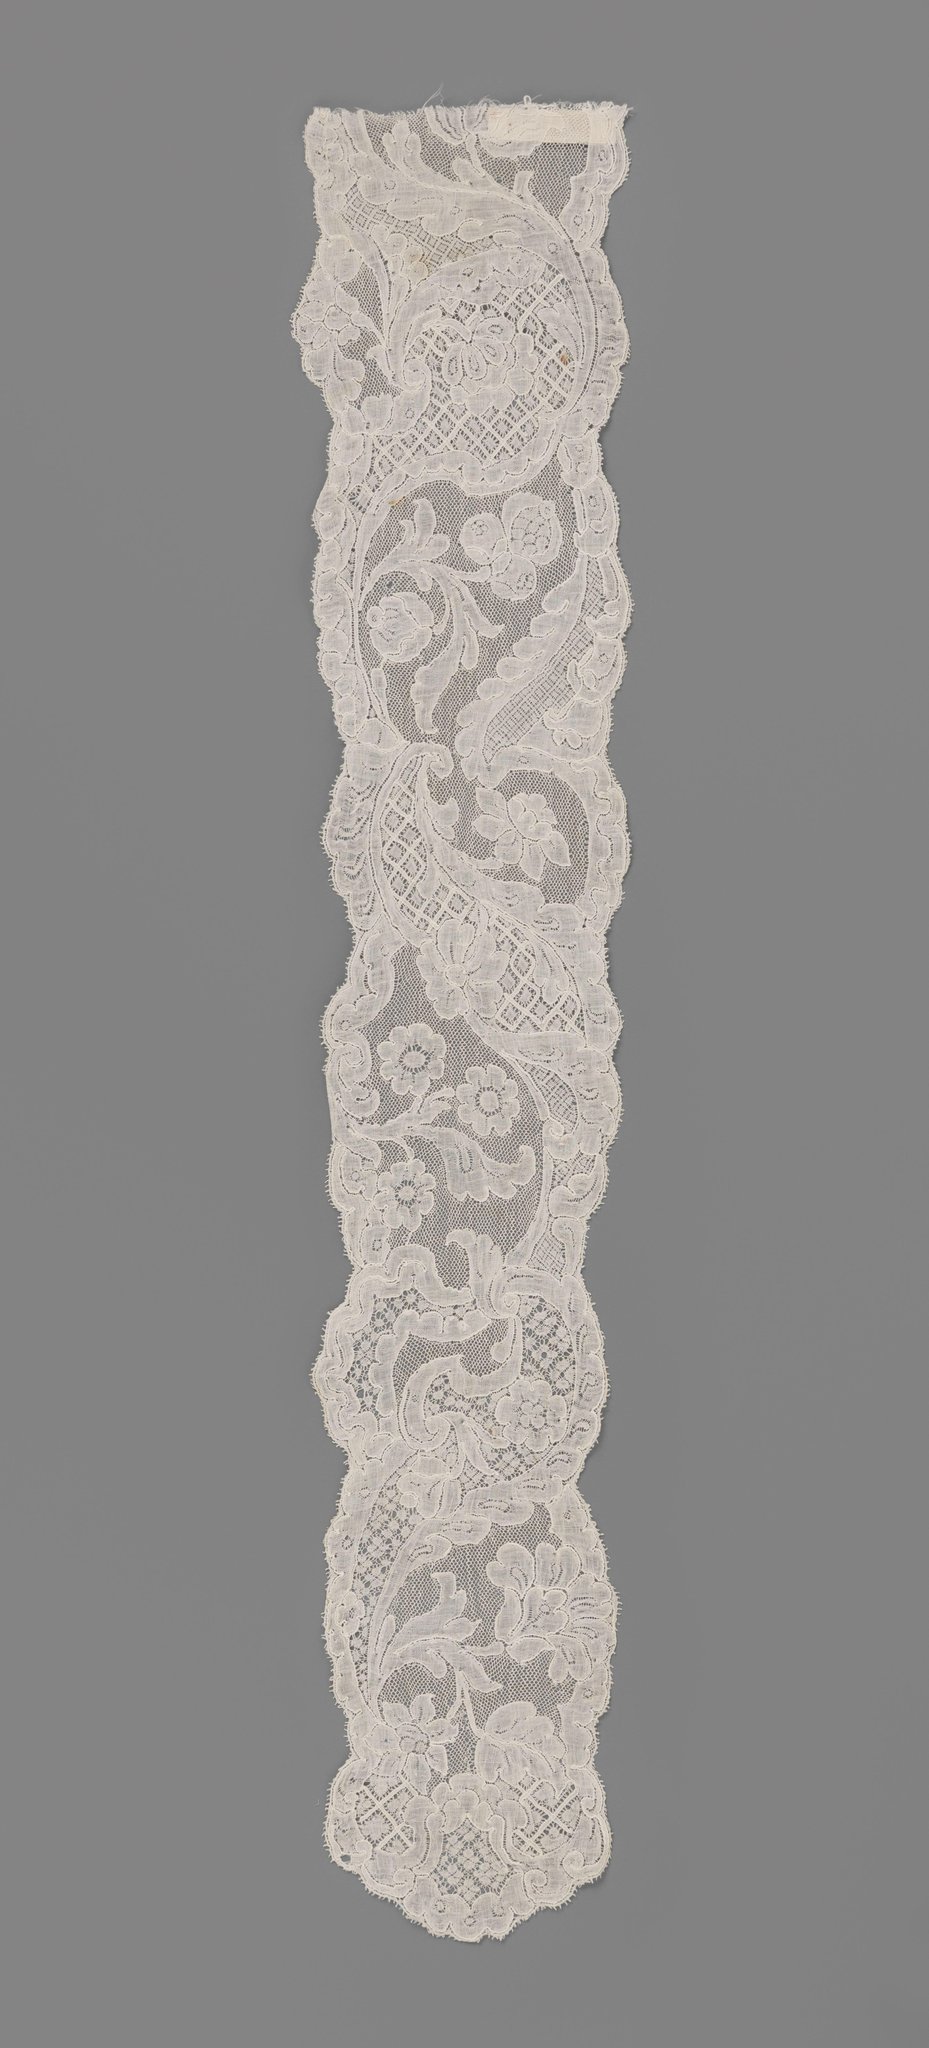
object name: womenswear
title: Mutsenslip (fragment) van Mechelse kant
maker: Anonymous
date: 1750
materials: linen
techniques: lace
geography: western europe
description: Barbe (fraqment) van kloskant. voluutranken met bloemen en bladeren op tullen grond. Schaduwen en verschillende vullingen, dikke contouren.